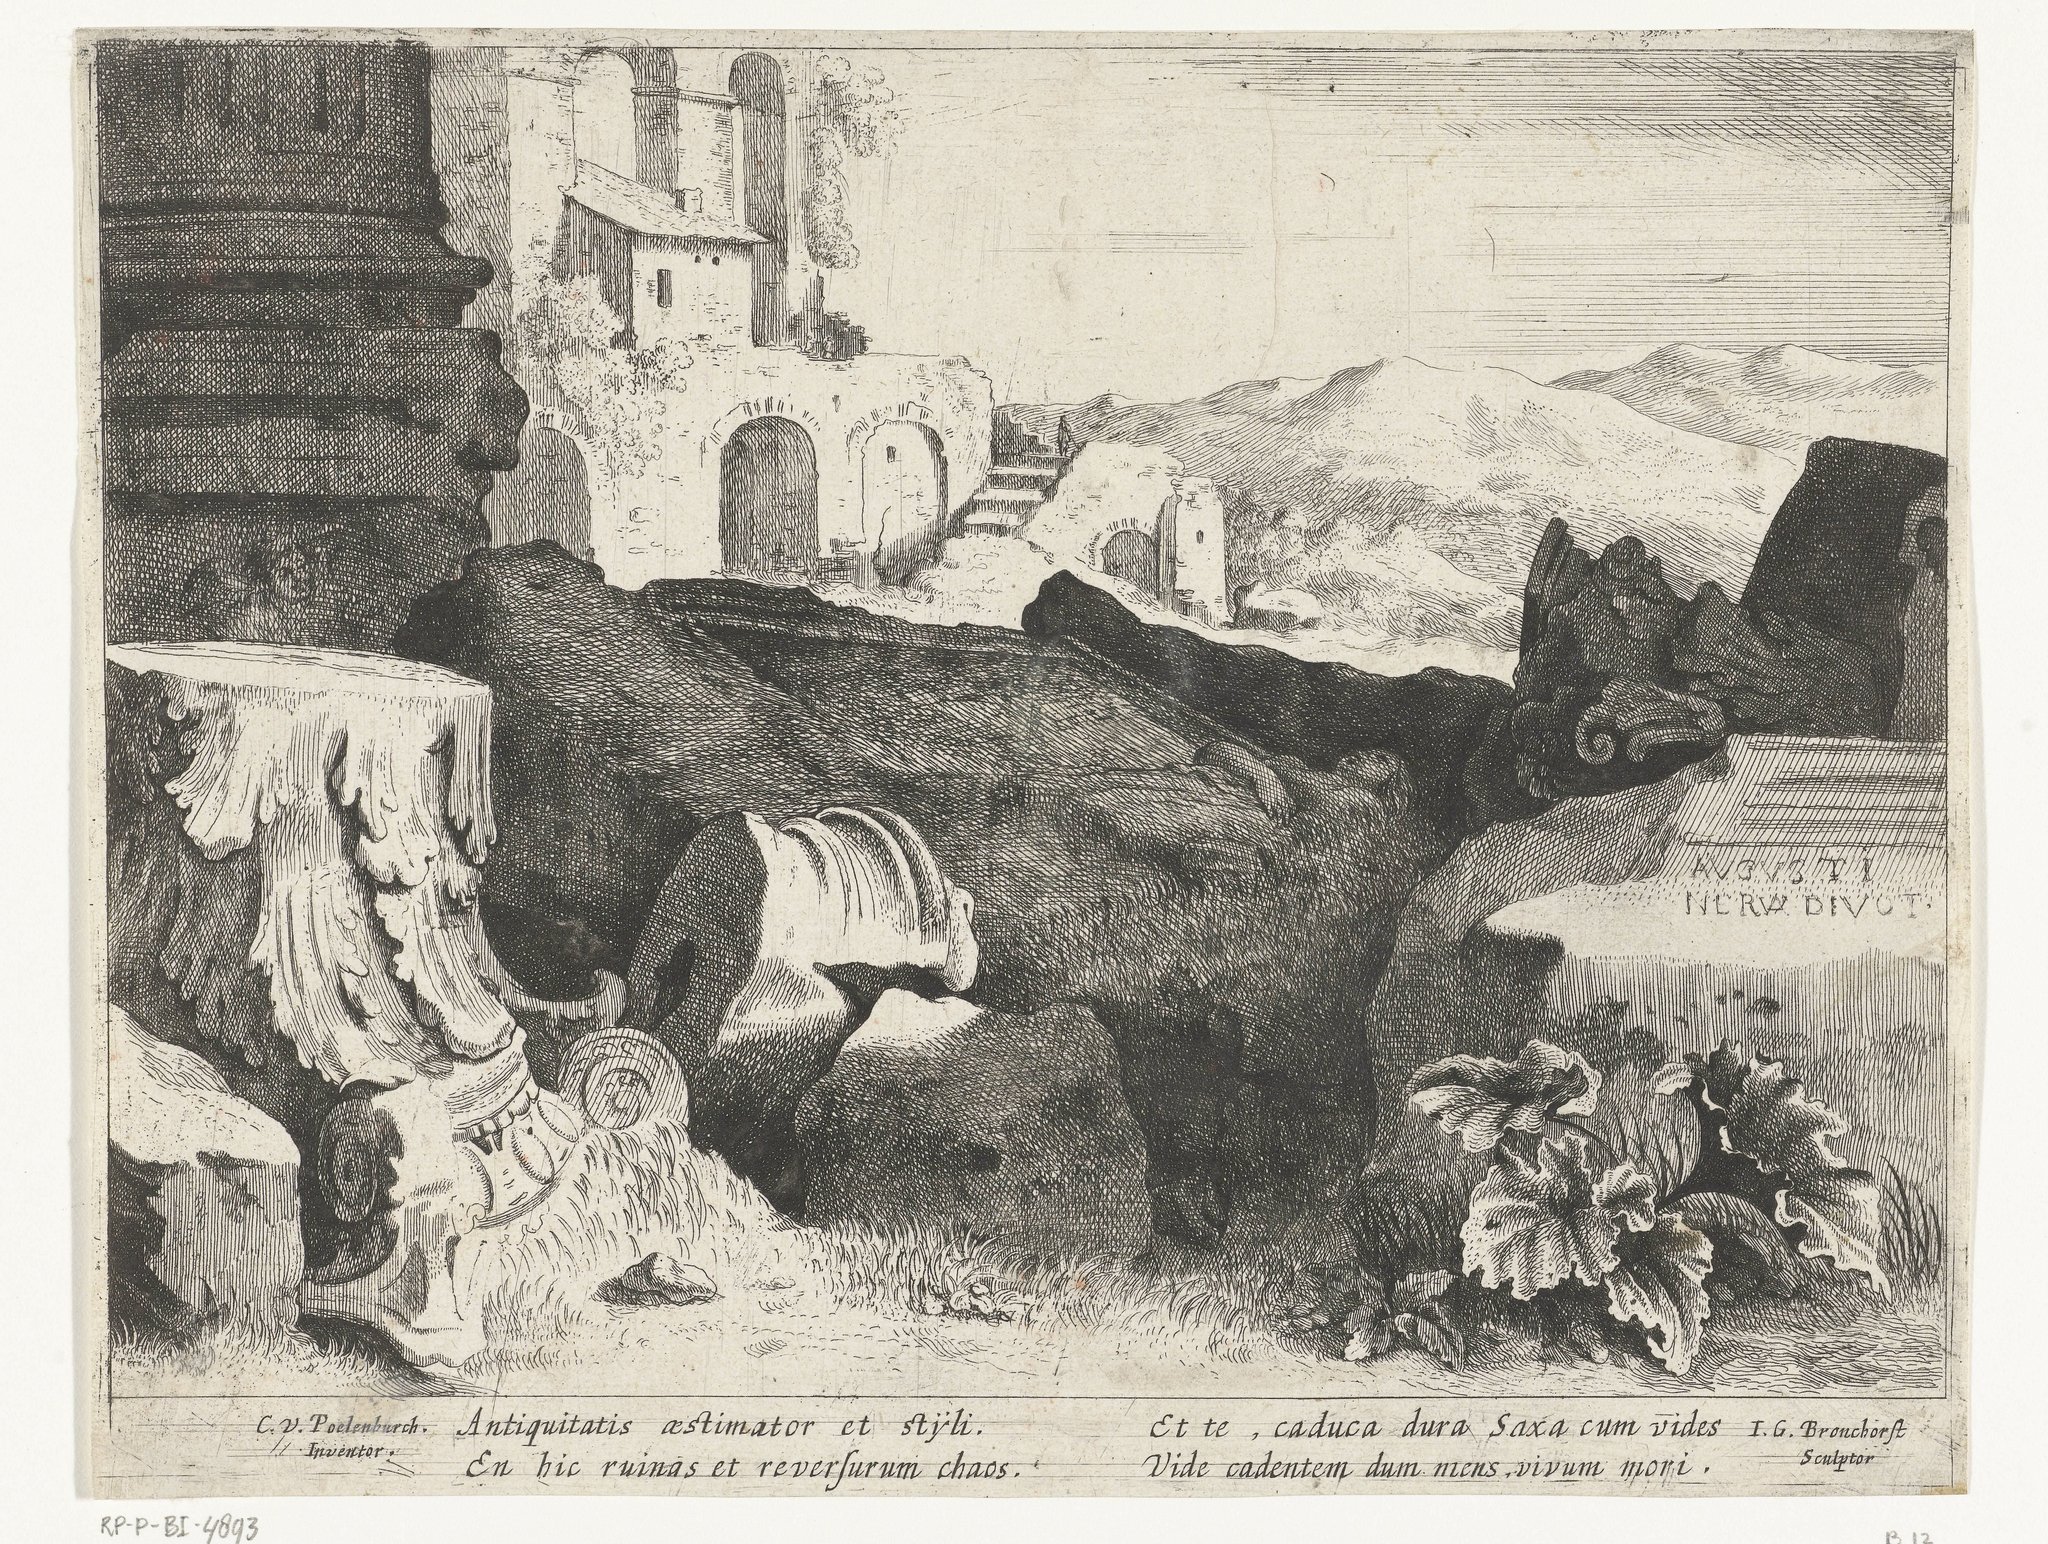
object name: print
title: Brokstukken van zuilen en kapitelen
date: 1613-1661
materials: paper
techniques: etching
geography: netherlands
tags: ruin of a building ~ architecture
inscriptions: collector's mark: Lugt 2228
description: Prent naar ontwerp van Cornelis van Poelenburch. Titelprent voor serie van negen prenten met Romeinse ruïne.